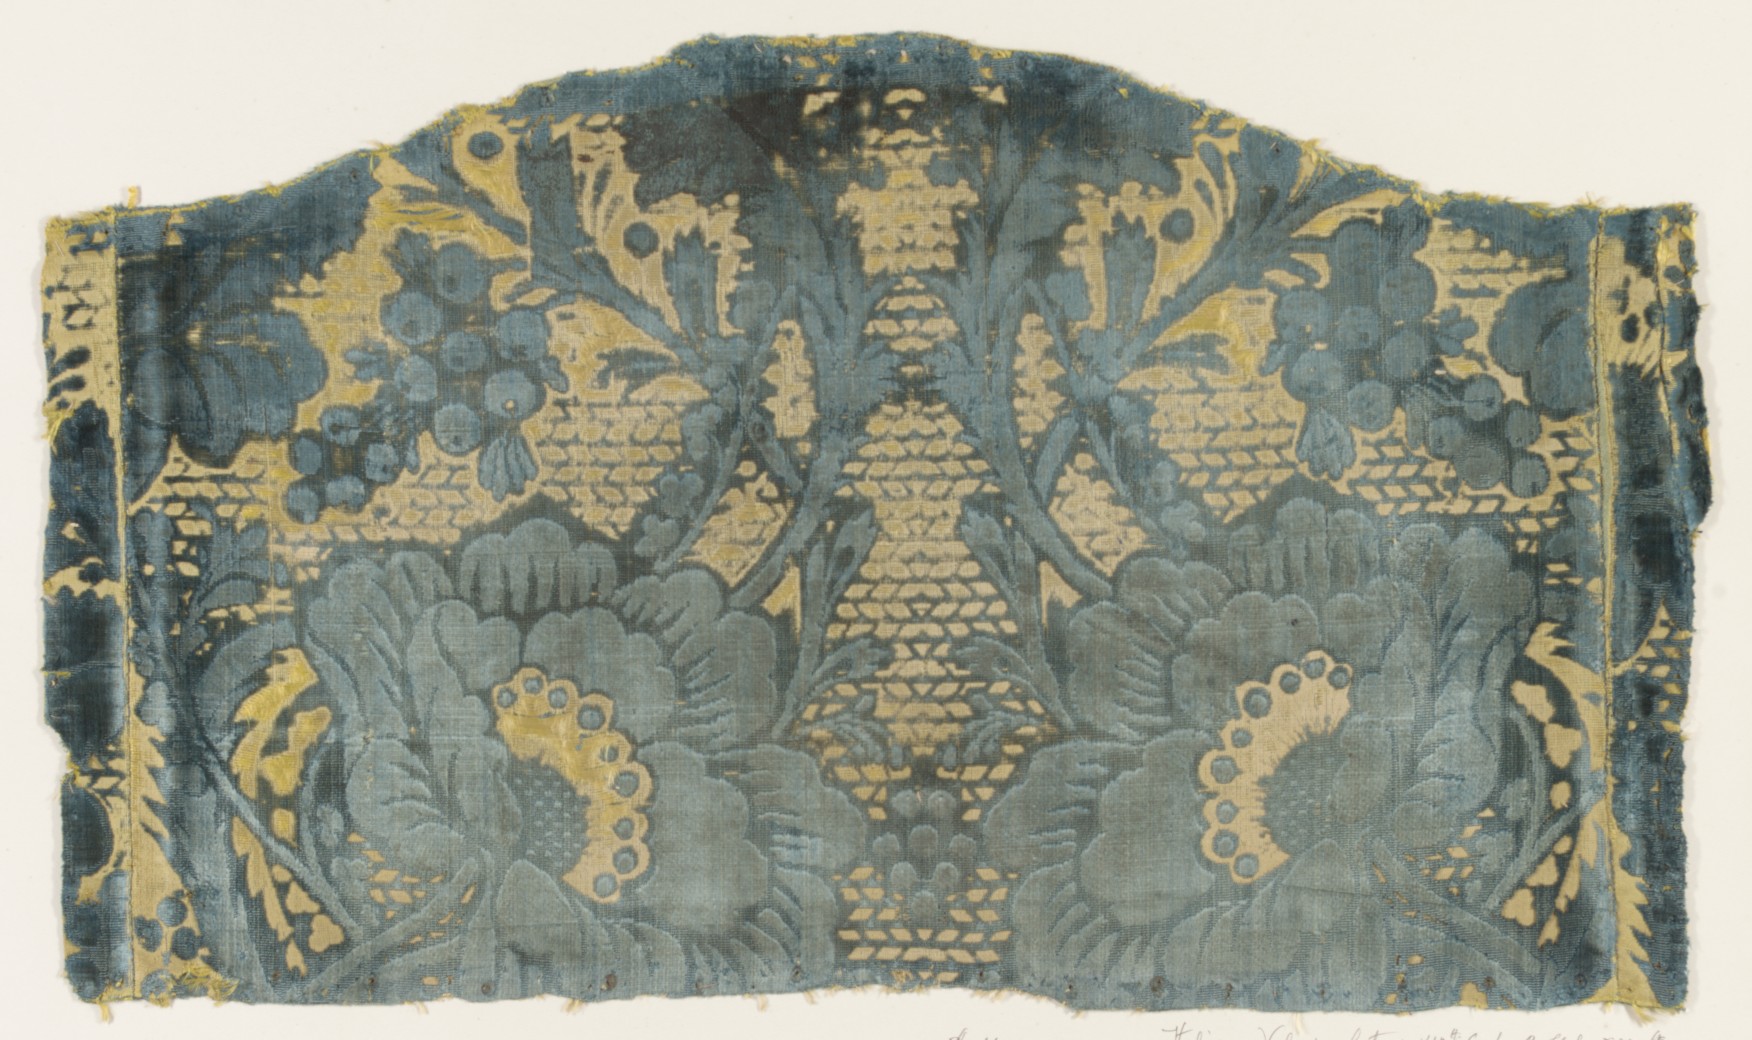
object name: fragment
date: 1667-1800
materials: silk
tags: flowers,leaves